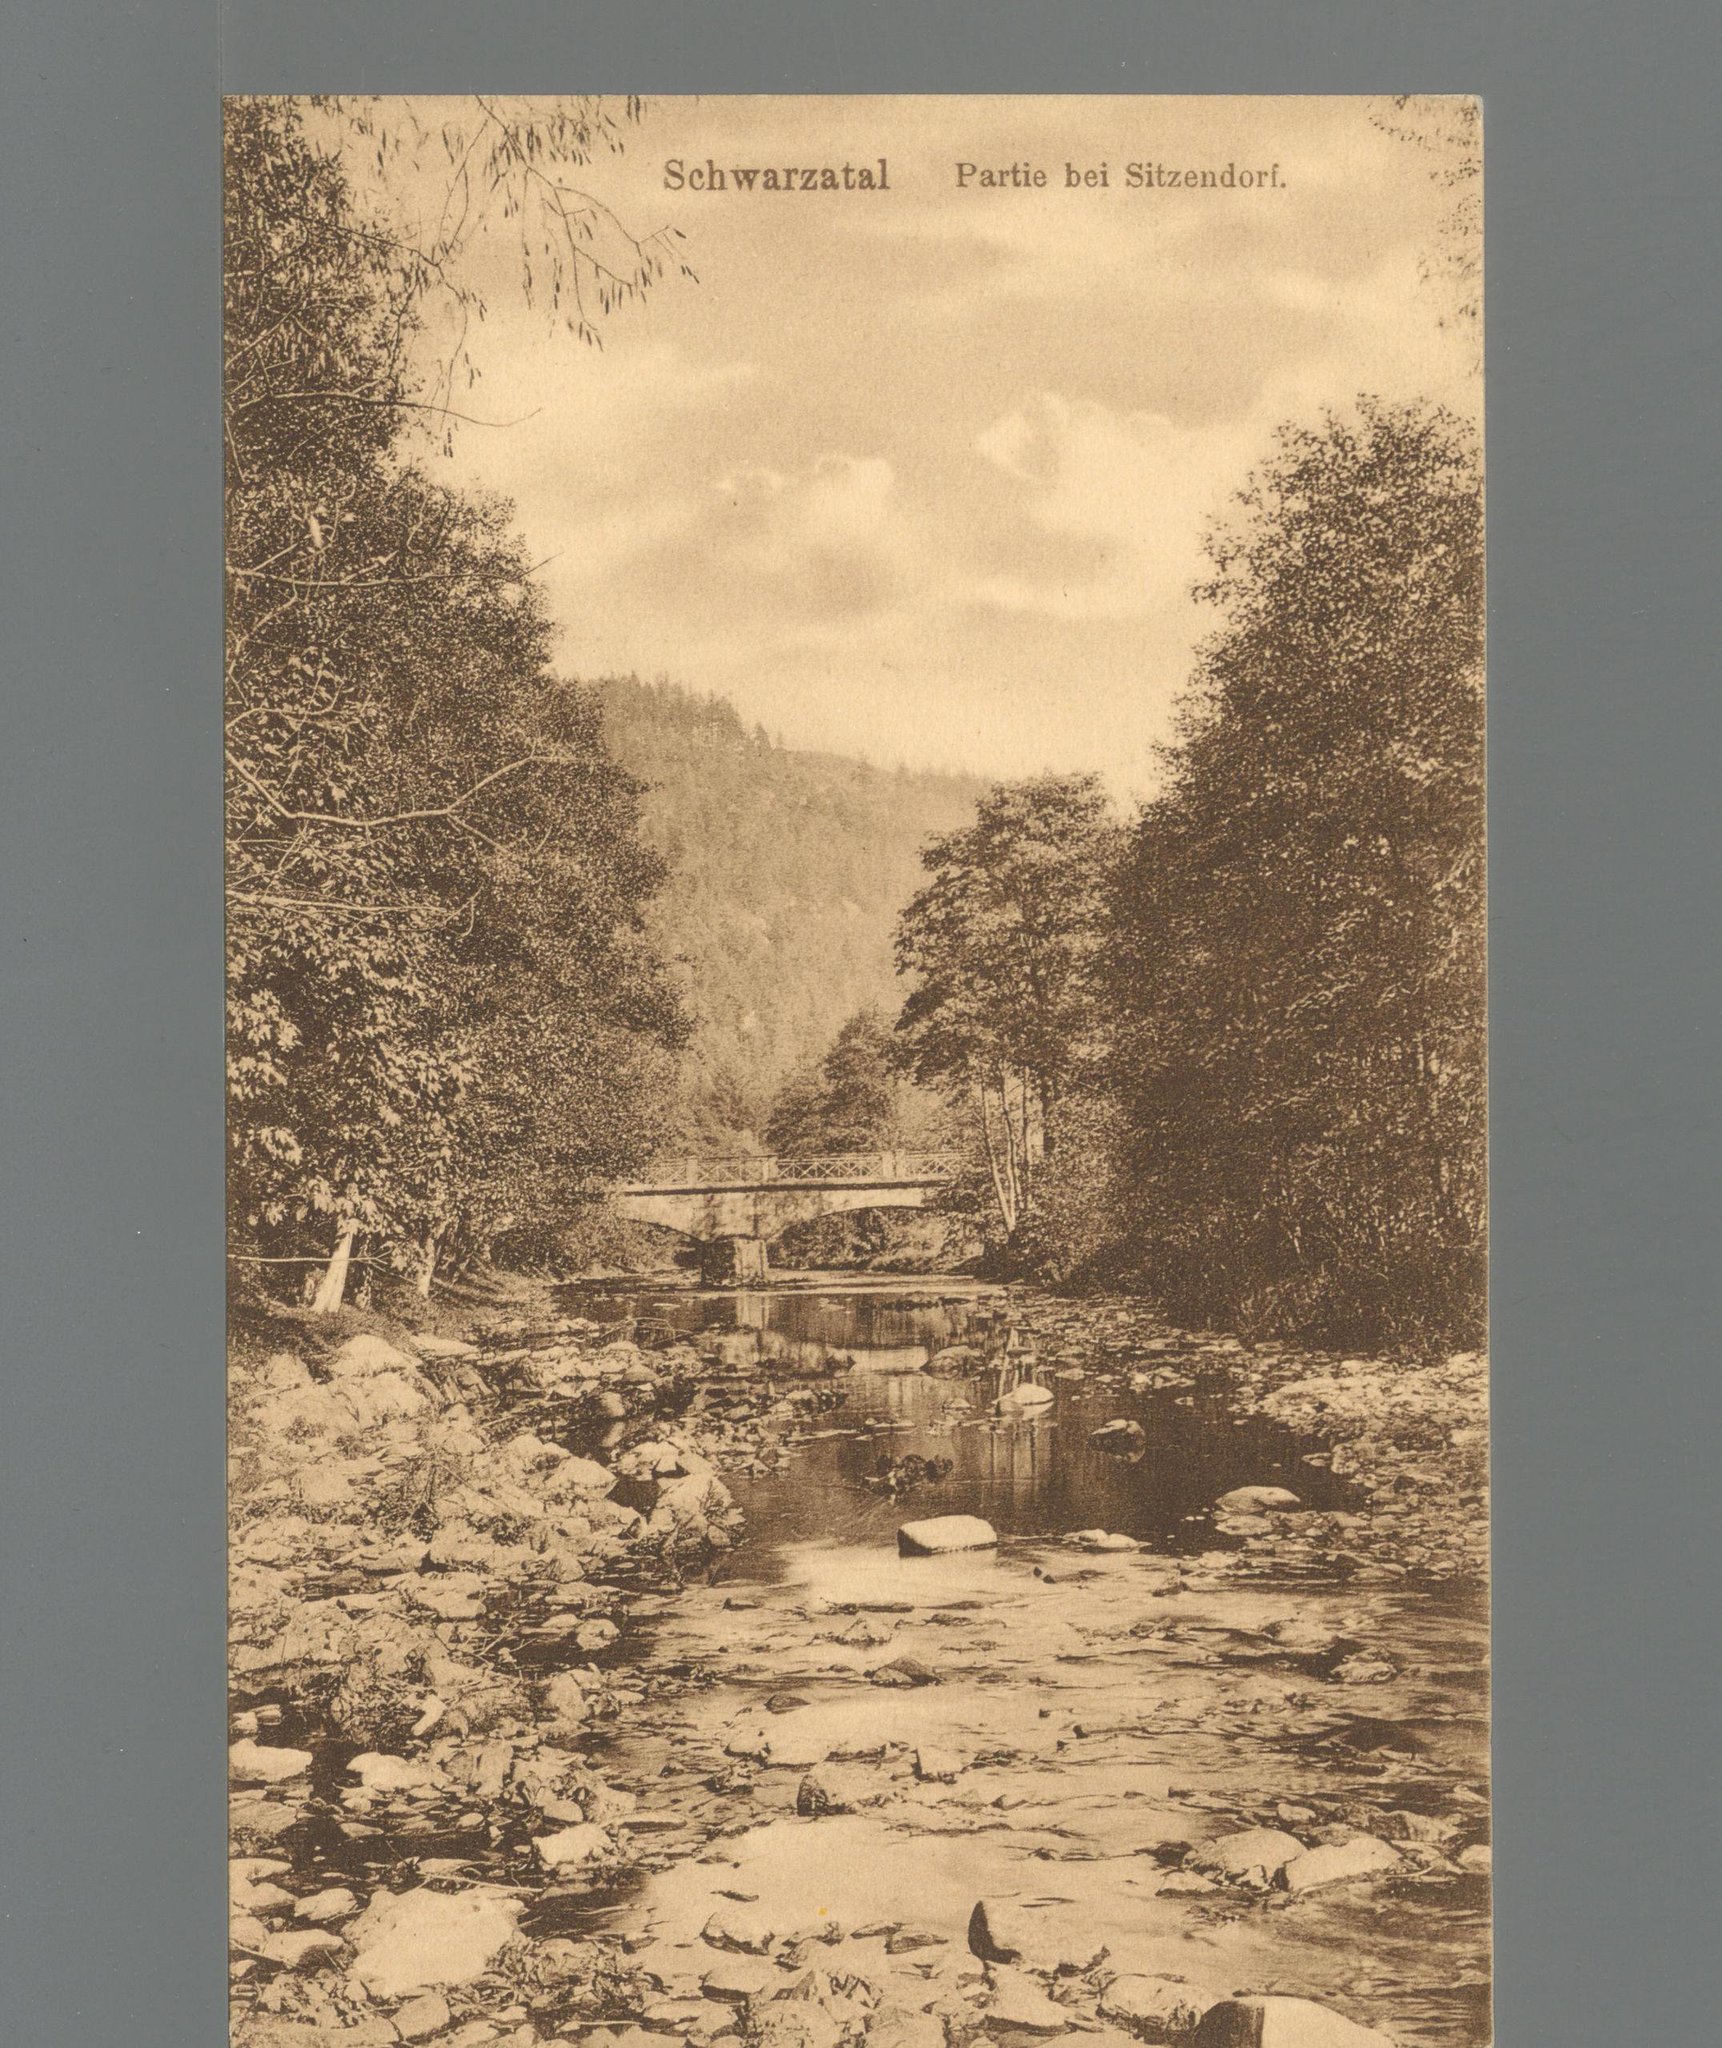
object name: photomechanical print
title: Schwarzatal. Partie bei Sitzendorf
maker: Anonymous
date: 1905-1909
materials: cardboard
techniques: photograph, writing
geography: trier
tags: river, bridge, mountains